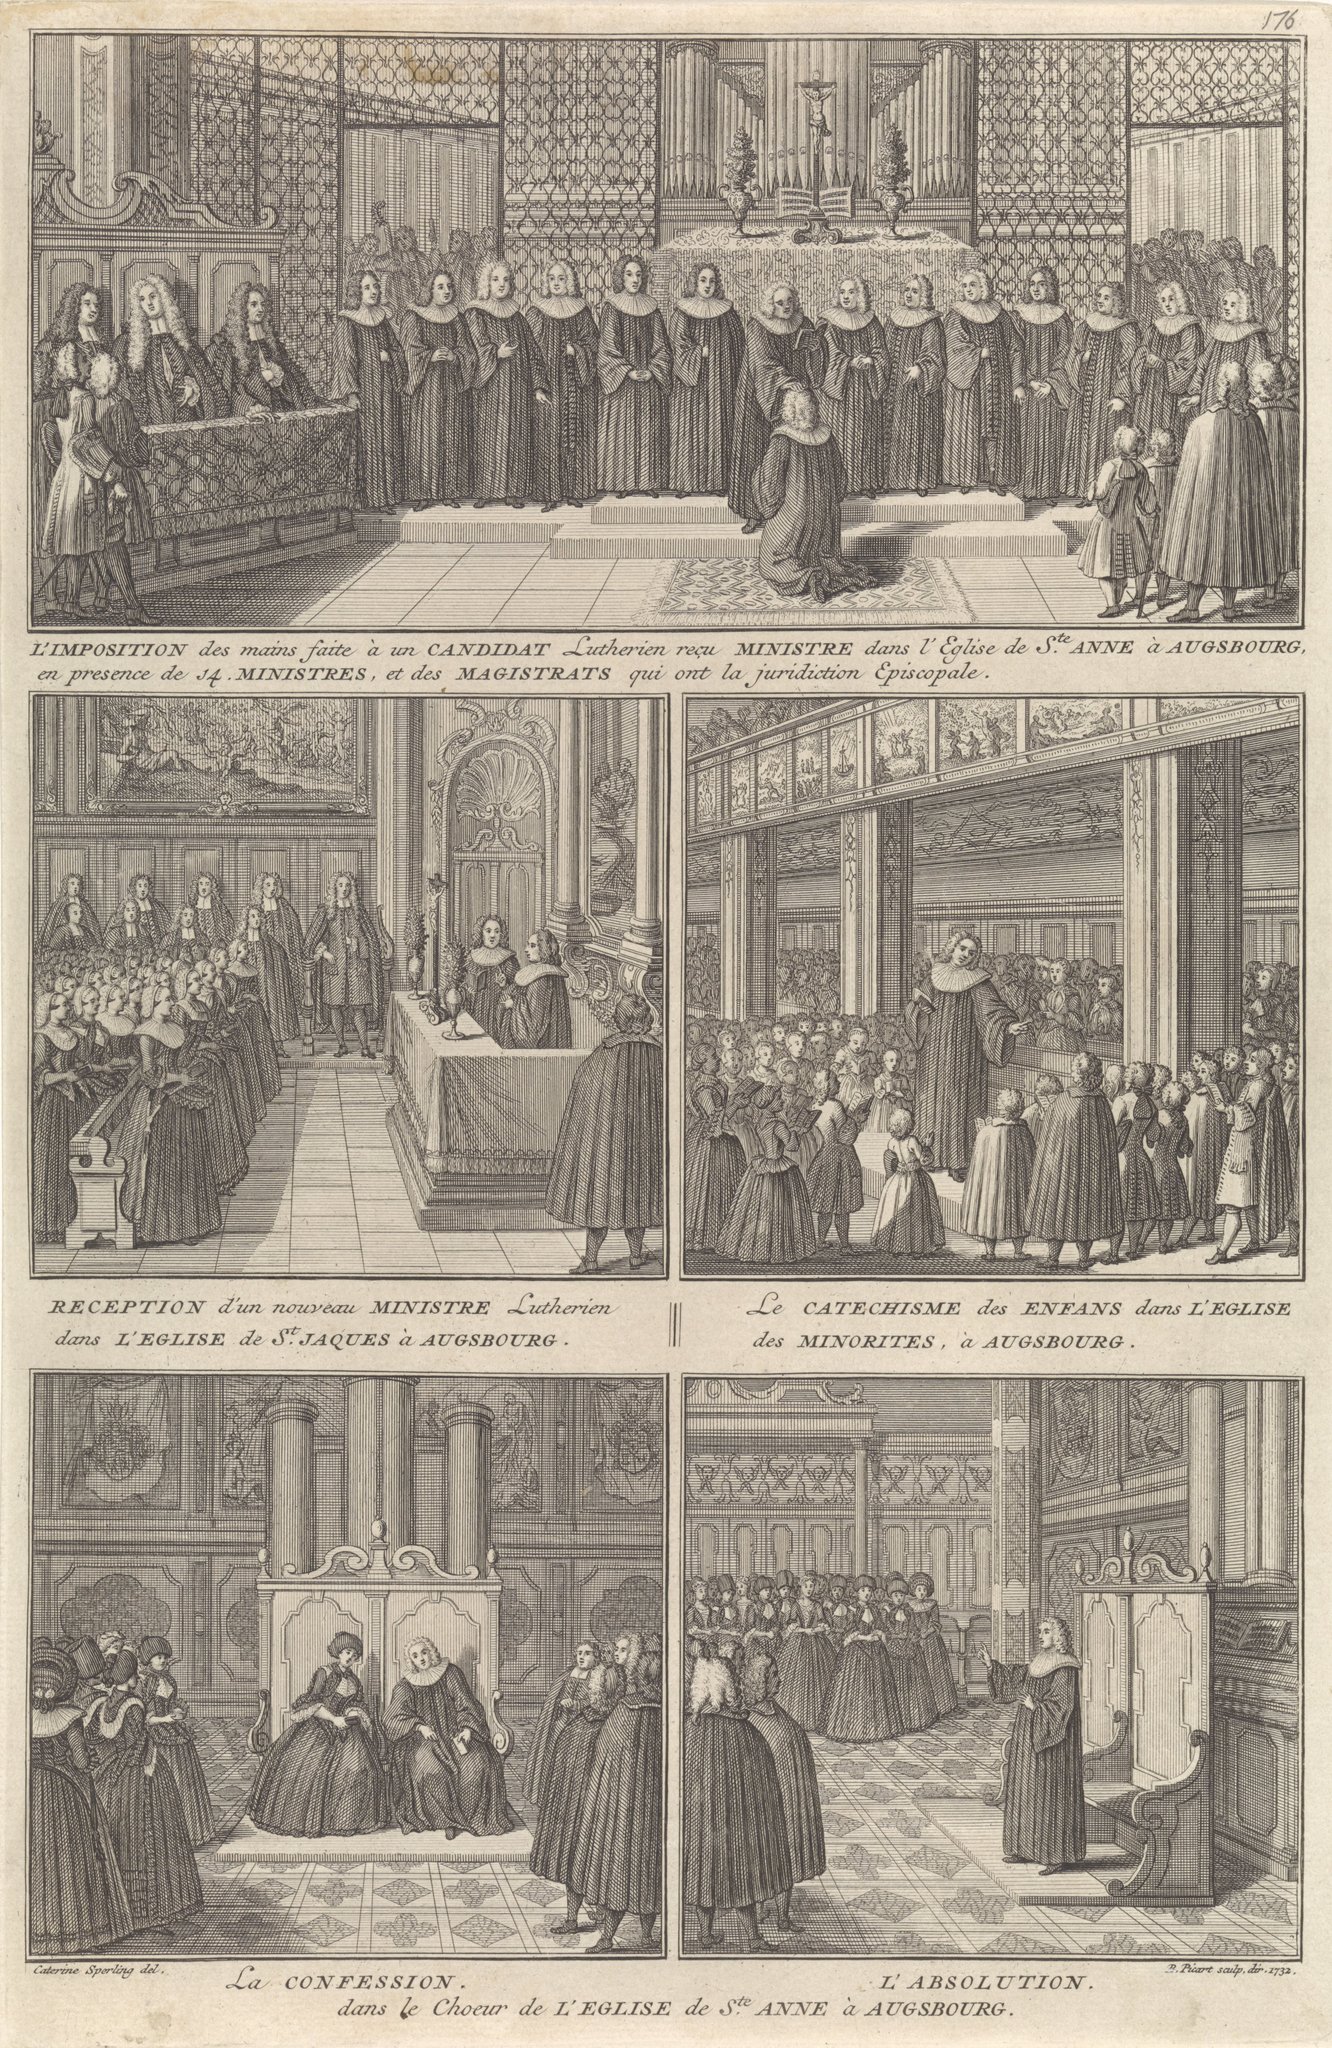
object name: print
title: Installatie van nieuwe predikanten, catechisatie en biecht bij de lutheranen in Augsburg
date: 1732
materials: paper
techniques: engraving, etching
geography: amsterdam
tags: catechism, organizational aspects ~ protestant churches, inauguration, consecration of person(s) ~ church, absolution, forgiveness of sins ~ part of the confession, confession; 'confessione sacramentale' (ripa) ~ the third of the seven sacraments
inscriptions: collector's mark: Lugt 2233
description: Blad met vijf voorstellingen van gebruiken bij de lutheranen van Augsburg. Boven: In de St. Anna kerk van Augsburg wordt een nieuwe predikant gezegend door hem de handen op te leggen. Midden links: Een nieuwe predikant wordt geïnstalleerd in de Kerk van de H. Jacobus van Augsburg. Midden rechts: Kinderen krijgen catechese van een predikant in de kerk van de Minorieten te Augsburg. Linksonder: Een predikant neemt de biecht af in de St. Anna kerk van Augsburg. Rechtsonder: Een predikant spreekt de absolutie uit over de kerkgangers in de St Anna kerk van Augsburg.